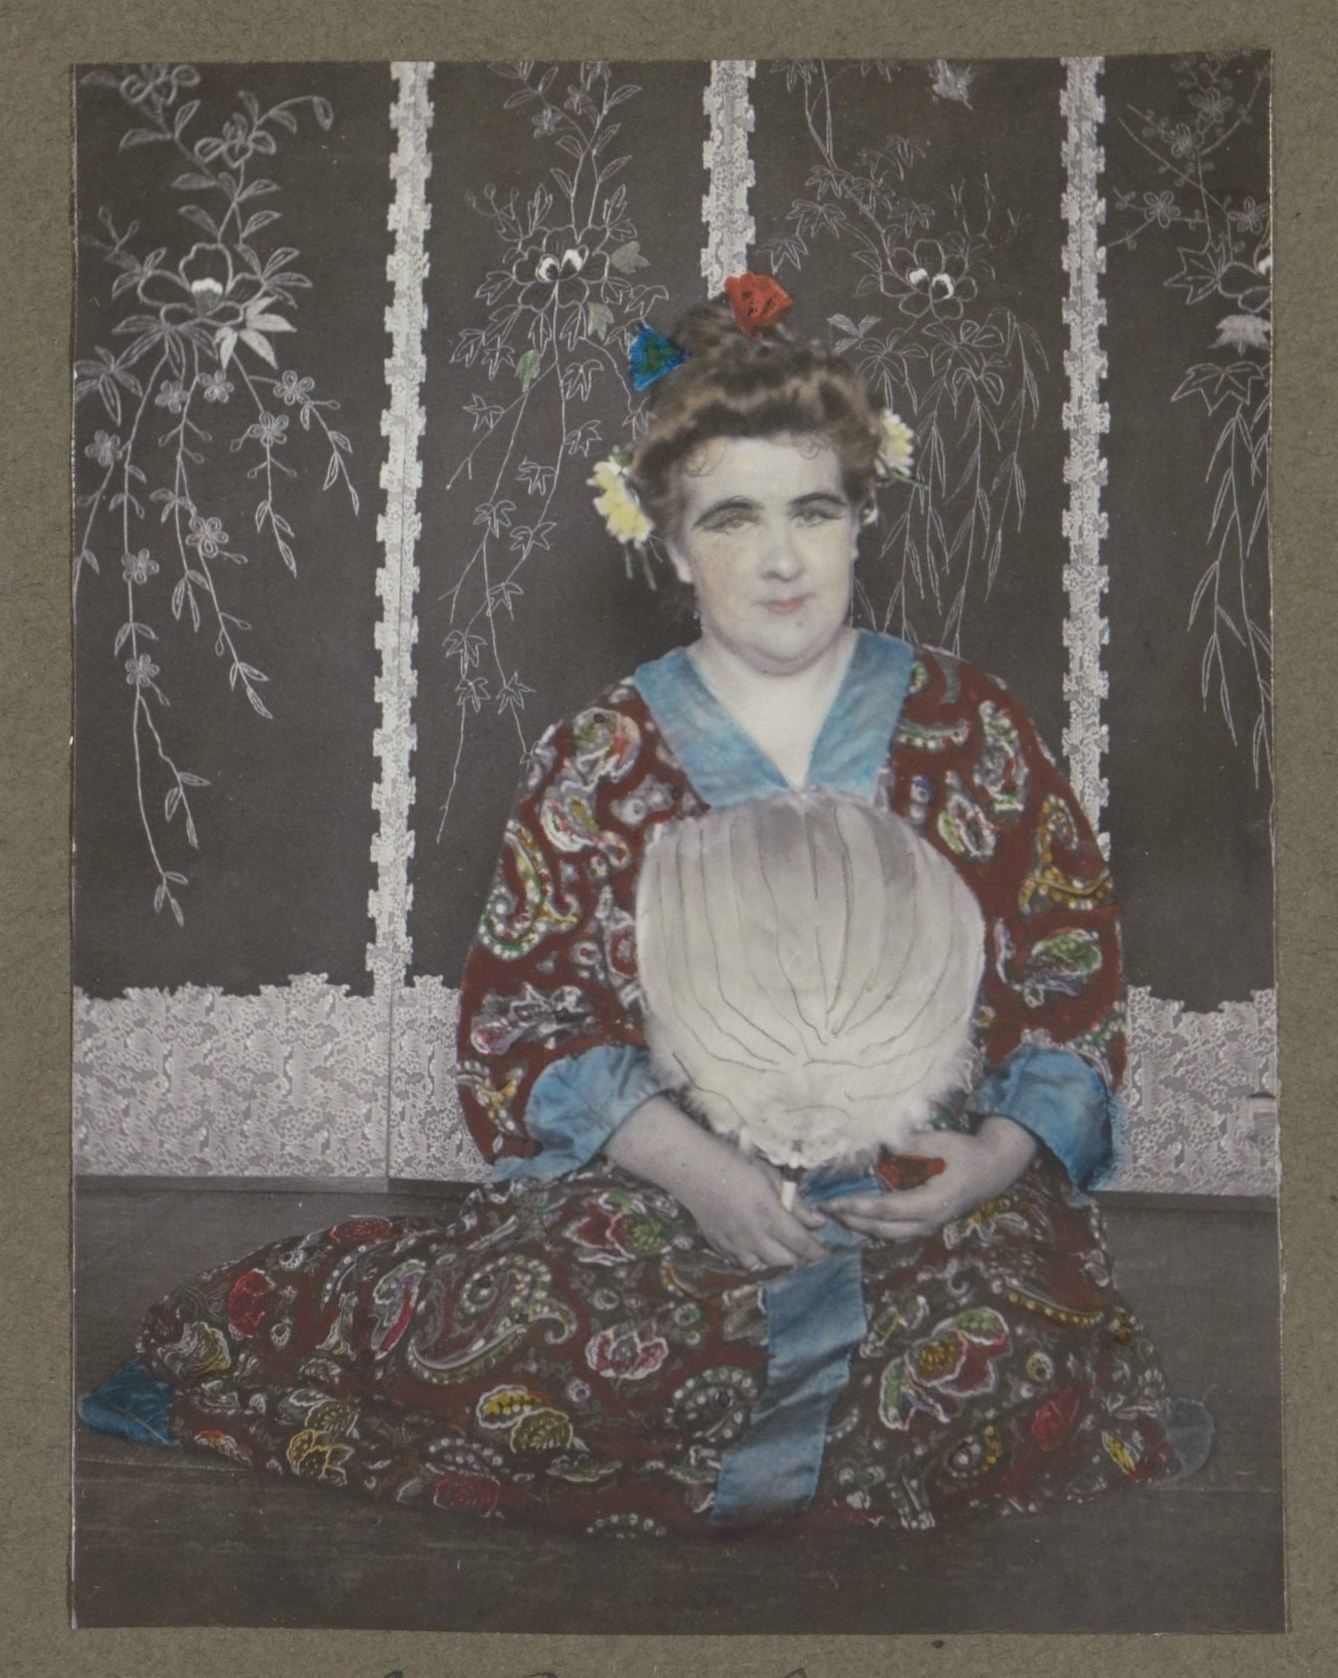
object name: photograph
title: als Geisha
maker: Anonymous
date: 1920-1930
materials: photographic support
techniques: hand coloring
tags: adult woman, dress-up party, courtesan, hetaera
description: Onderdeel van fotoalbum van een onbekende Nederlandse familie met opnames van Suriname, Europa en Nederlands-Indië.